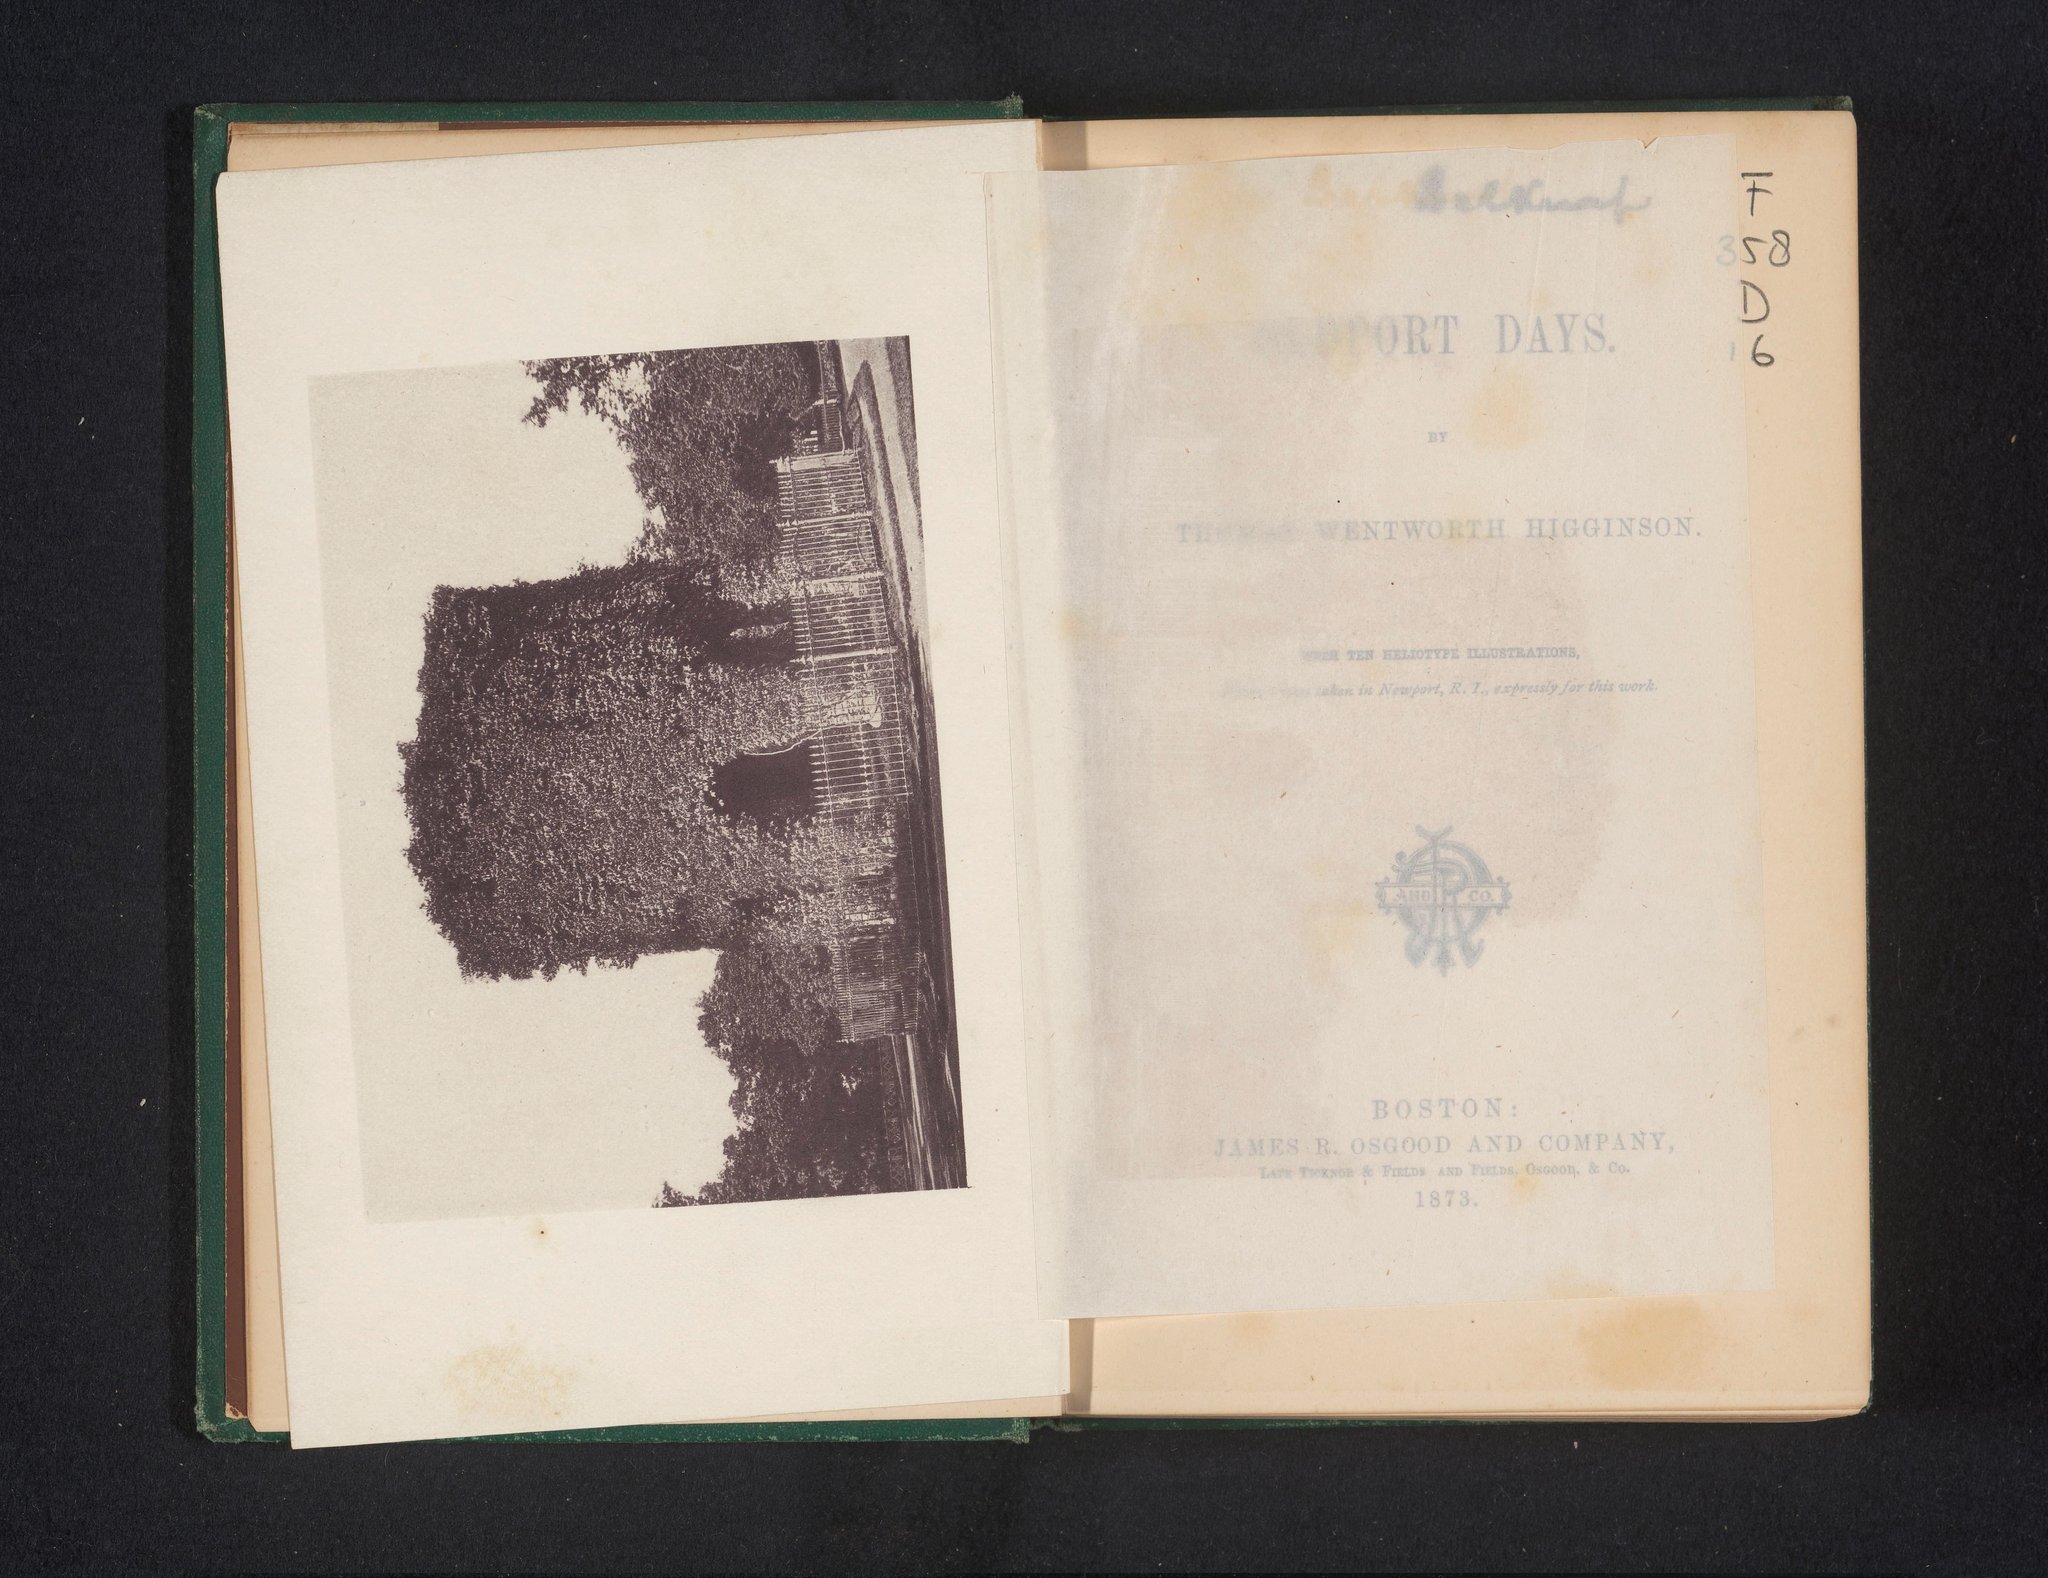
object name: page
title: Ruïne van Newport Tower te Newport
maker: Anonymous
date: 1868-1873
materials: paper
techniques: photograph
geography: newport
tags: ruin of a building ~ architecture